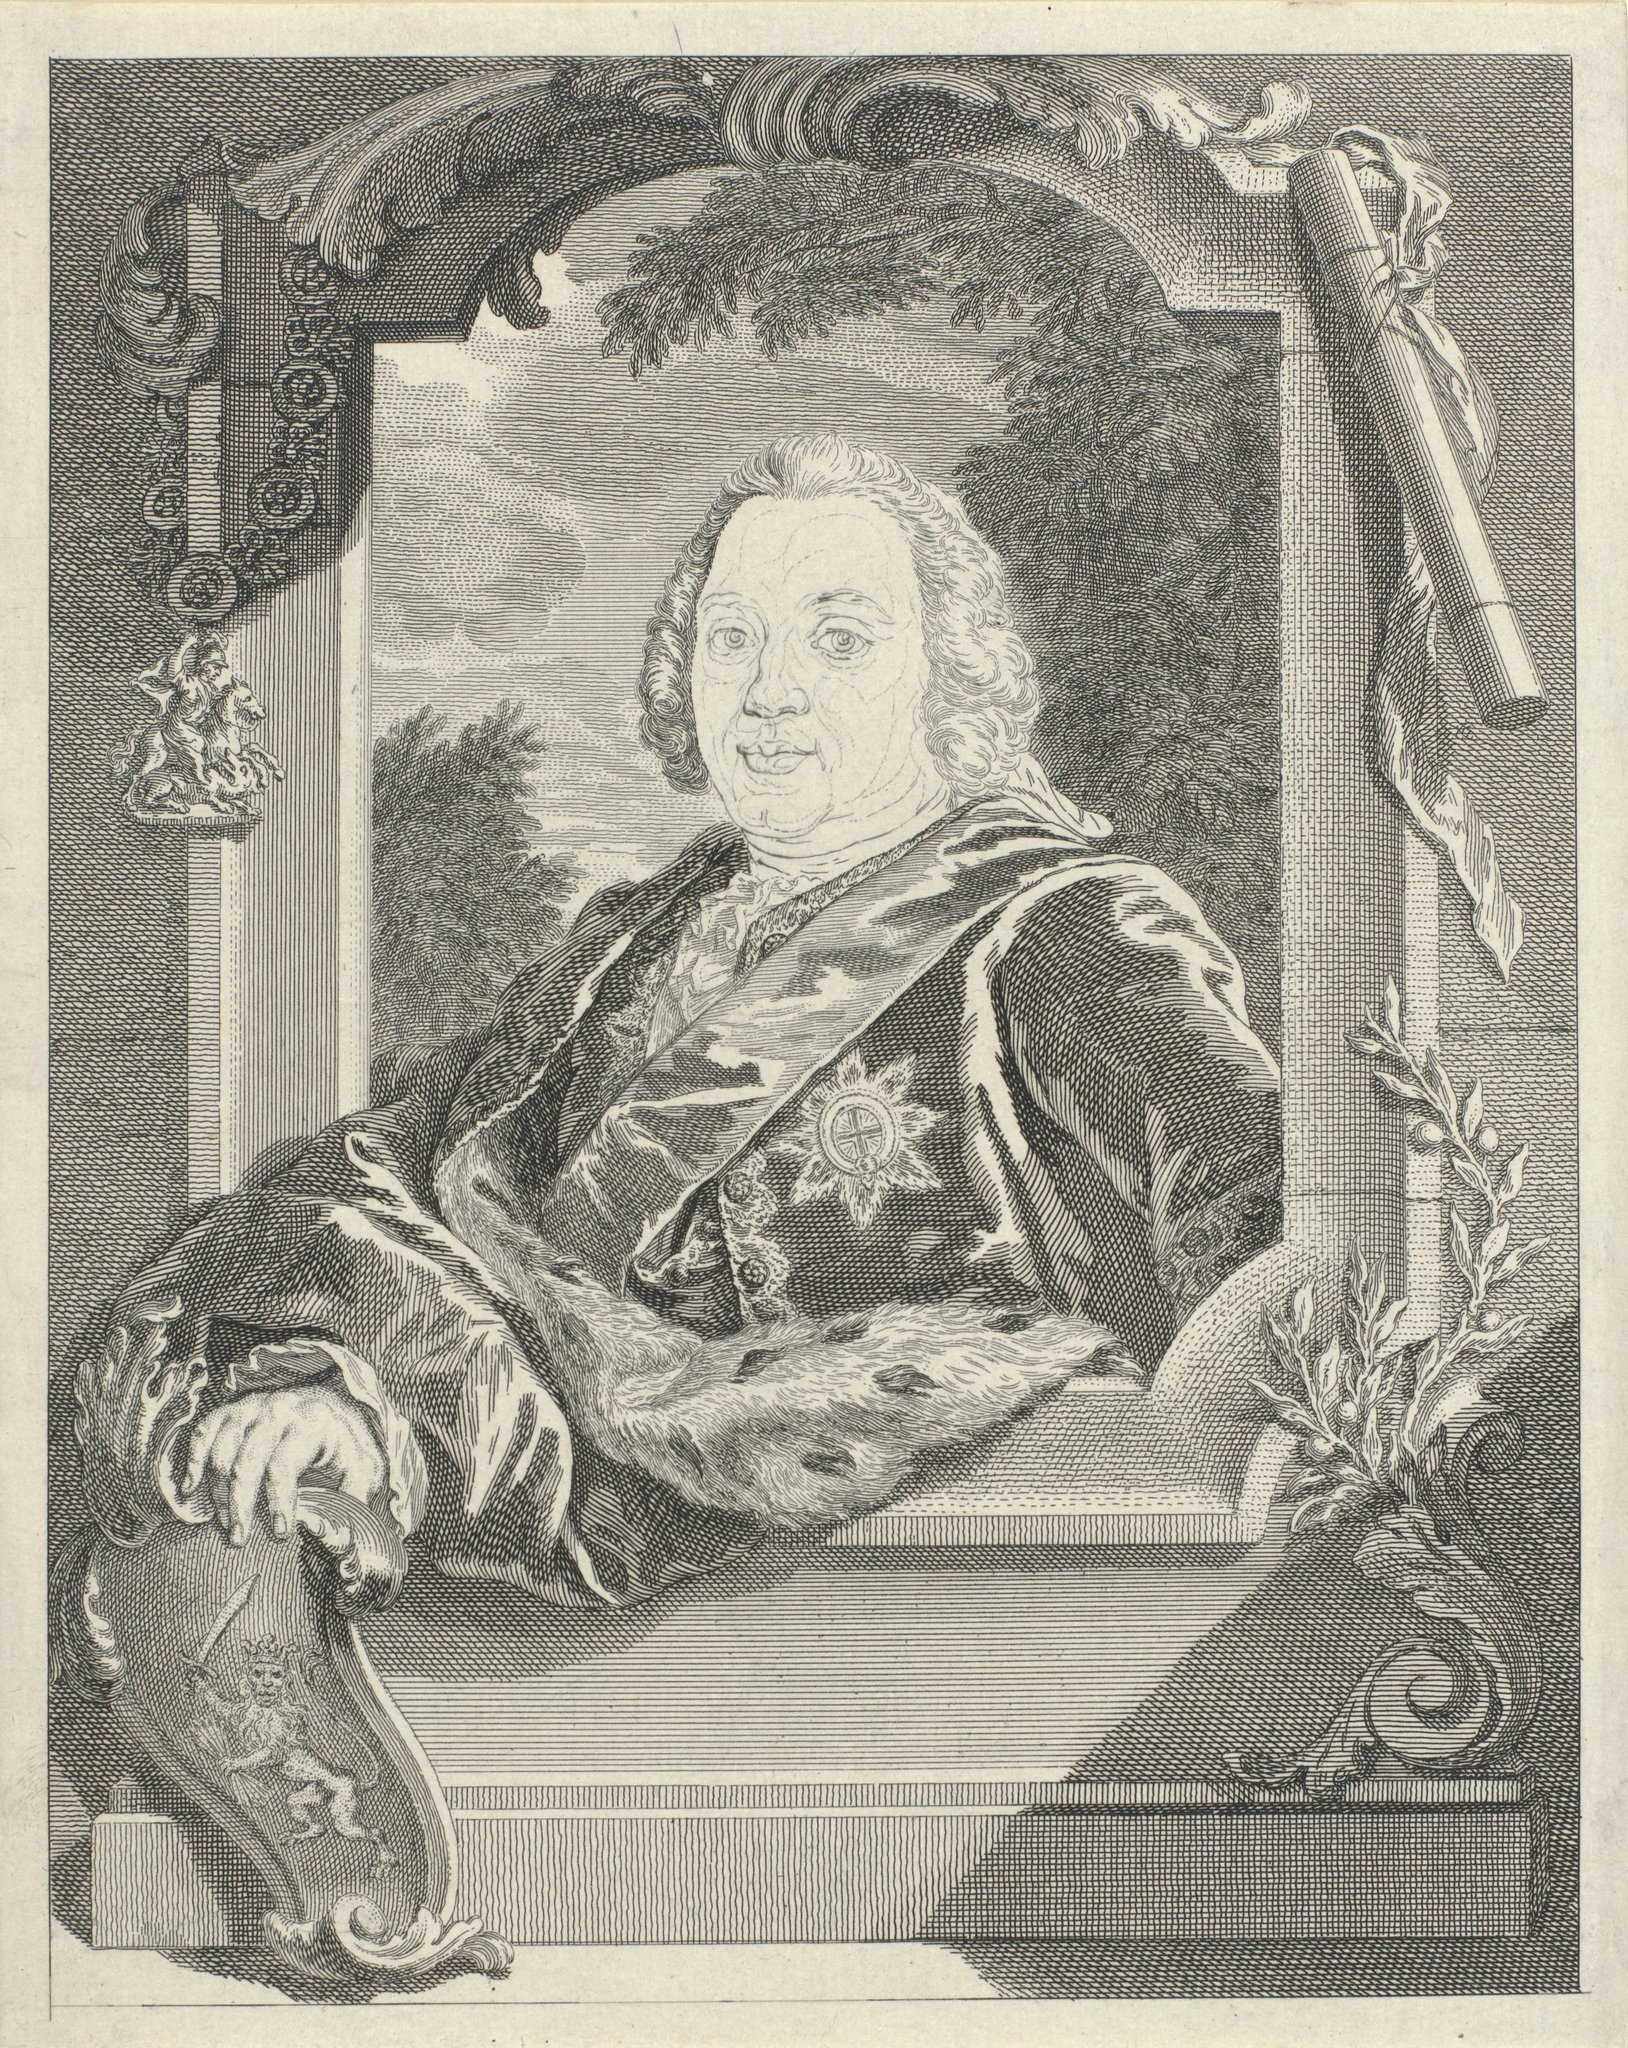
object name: print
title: Portret van Willem IV, prins van Oranje-Nassau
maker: pieter tanjé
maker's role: draughtsman, print maker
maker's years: 1706-1761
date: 1750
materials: paper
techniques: engraving, etching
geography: amsterdam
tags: the hague, willem iv (prins van oranje-nassau), knighthood order (garter) - insignia of a knighthood order, e.g.: badge, chain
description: De hier vermelde titel verwijst naar de hoogst verkregen titel van de geportretteerde, niet per se naar de titel die de geportretteerde op deze voorstelling draagt.